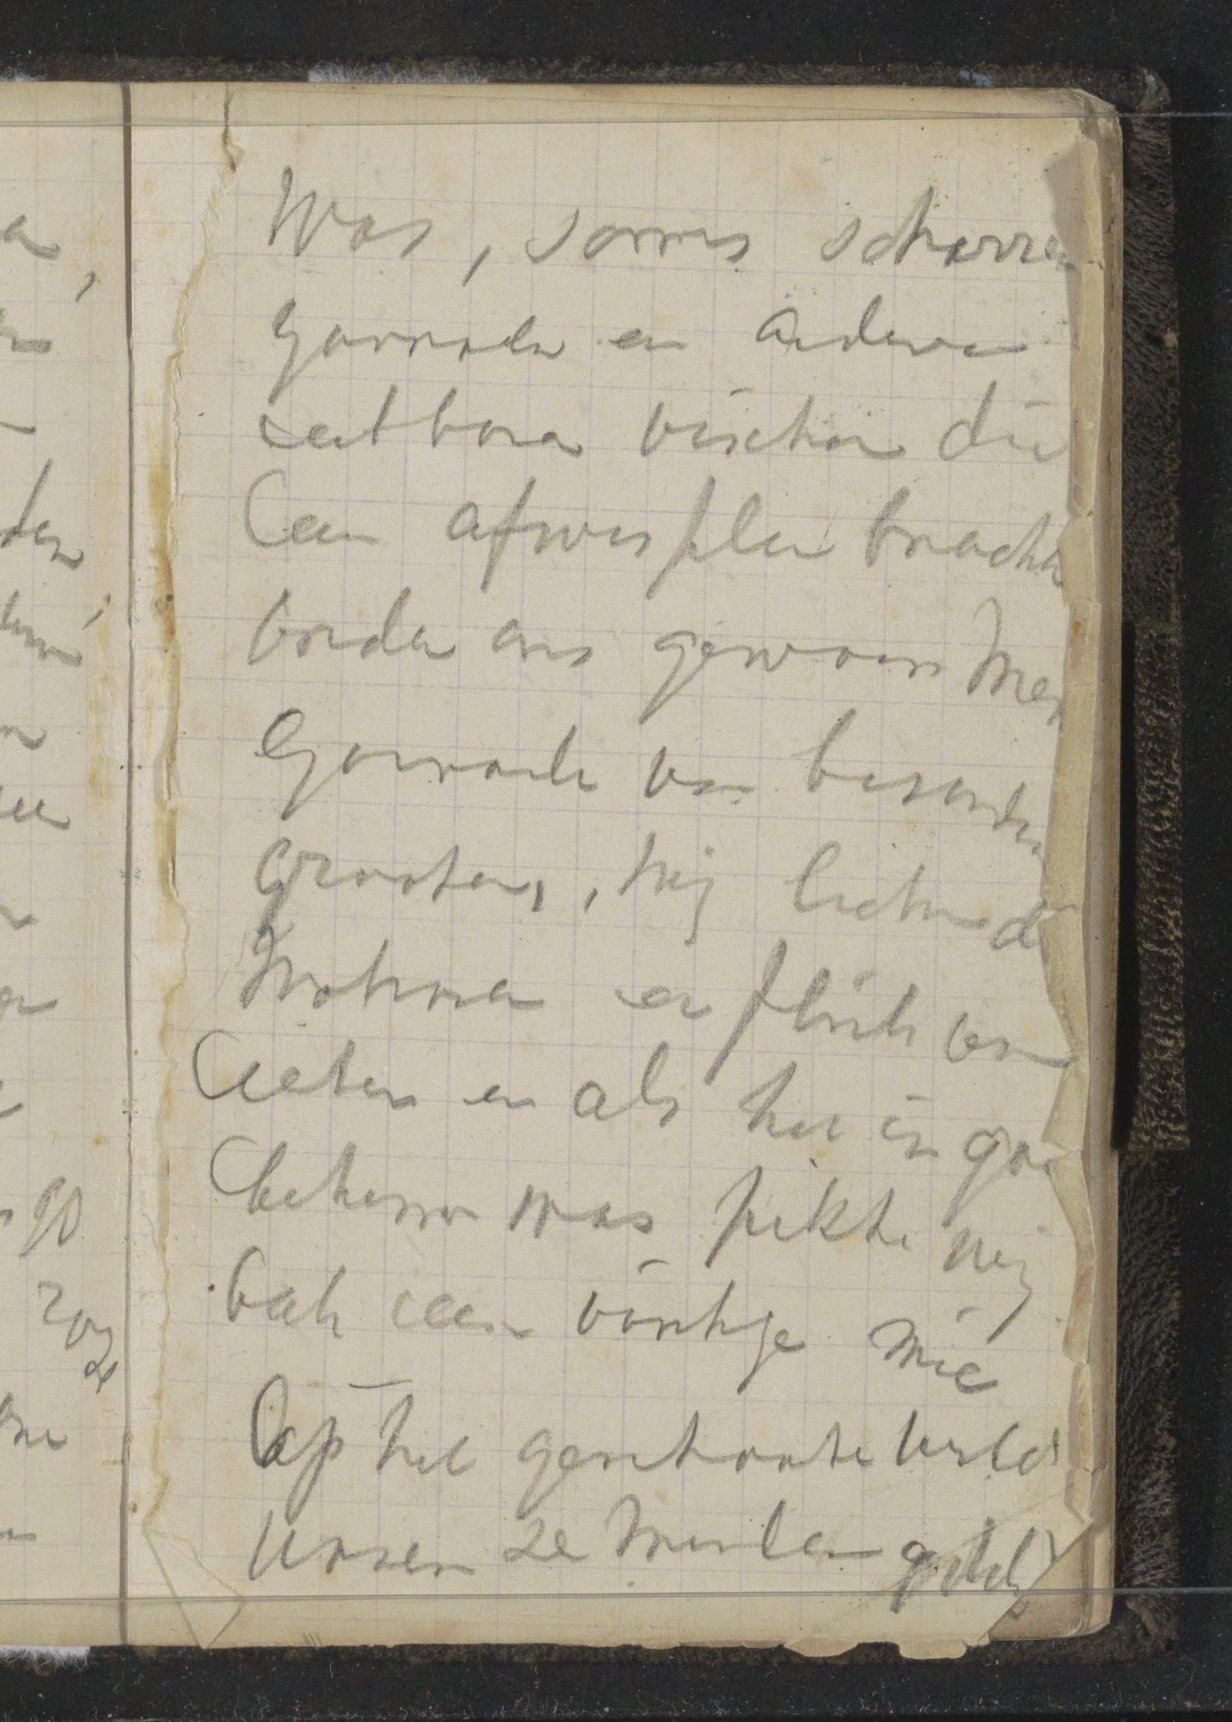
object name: sketchbook leaf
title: Reisverslag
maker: louis apol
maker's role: draughtsman, painter, print maker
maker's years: 1850-1936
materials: pencil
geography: novaya zemlya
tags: nova zembla expedities 1880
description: Blad 92 recto uit een schetsboek met 110 bladen betekend tijdens de expeditie naar Nova Zembla in 1880.